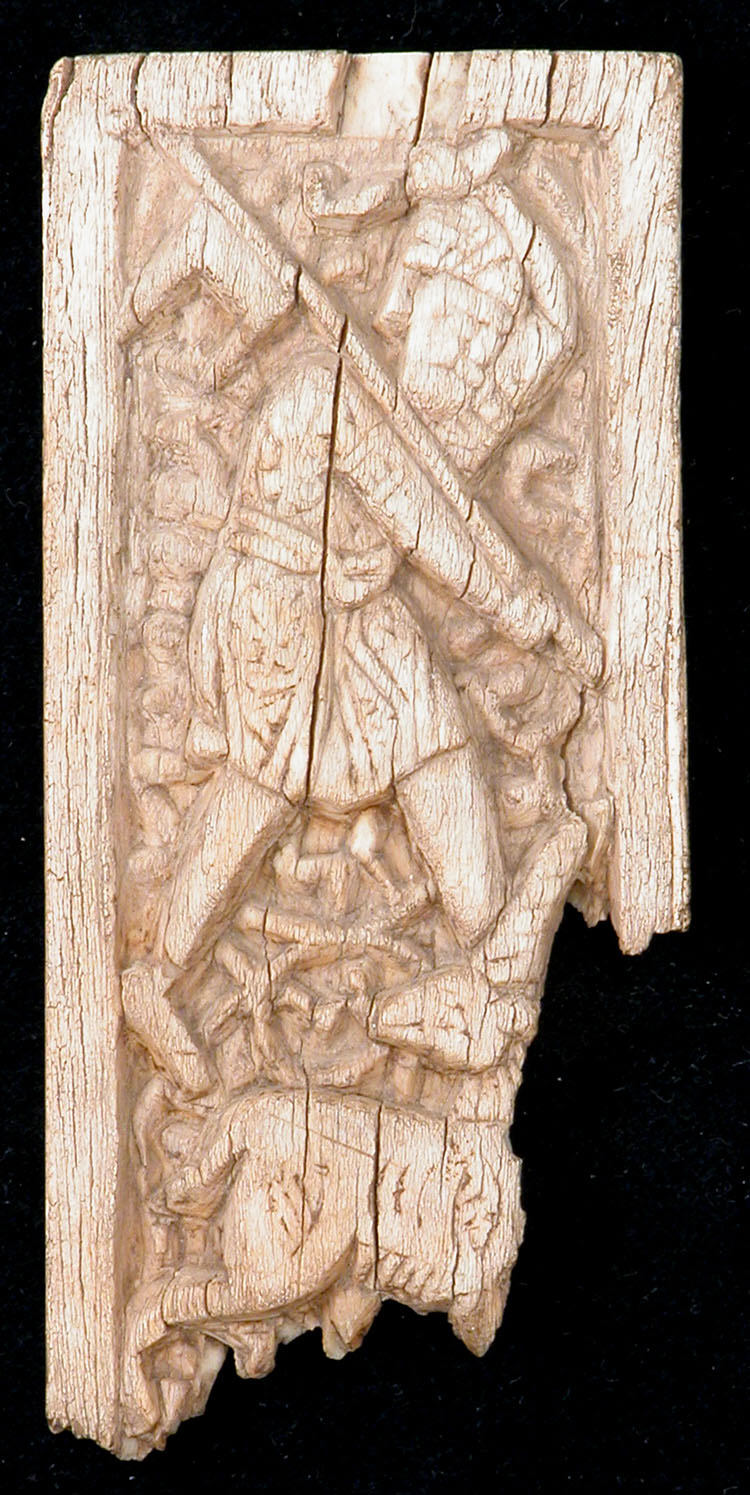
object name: fragment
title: Fragment of a Panel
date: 1001-1100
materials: bone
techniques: carving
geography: egypt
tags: men